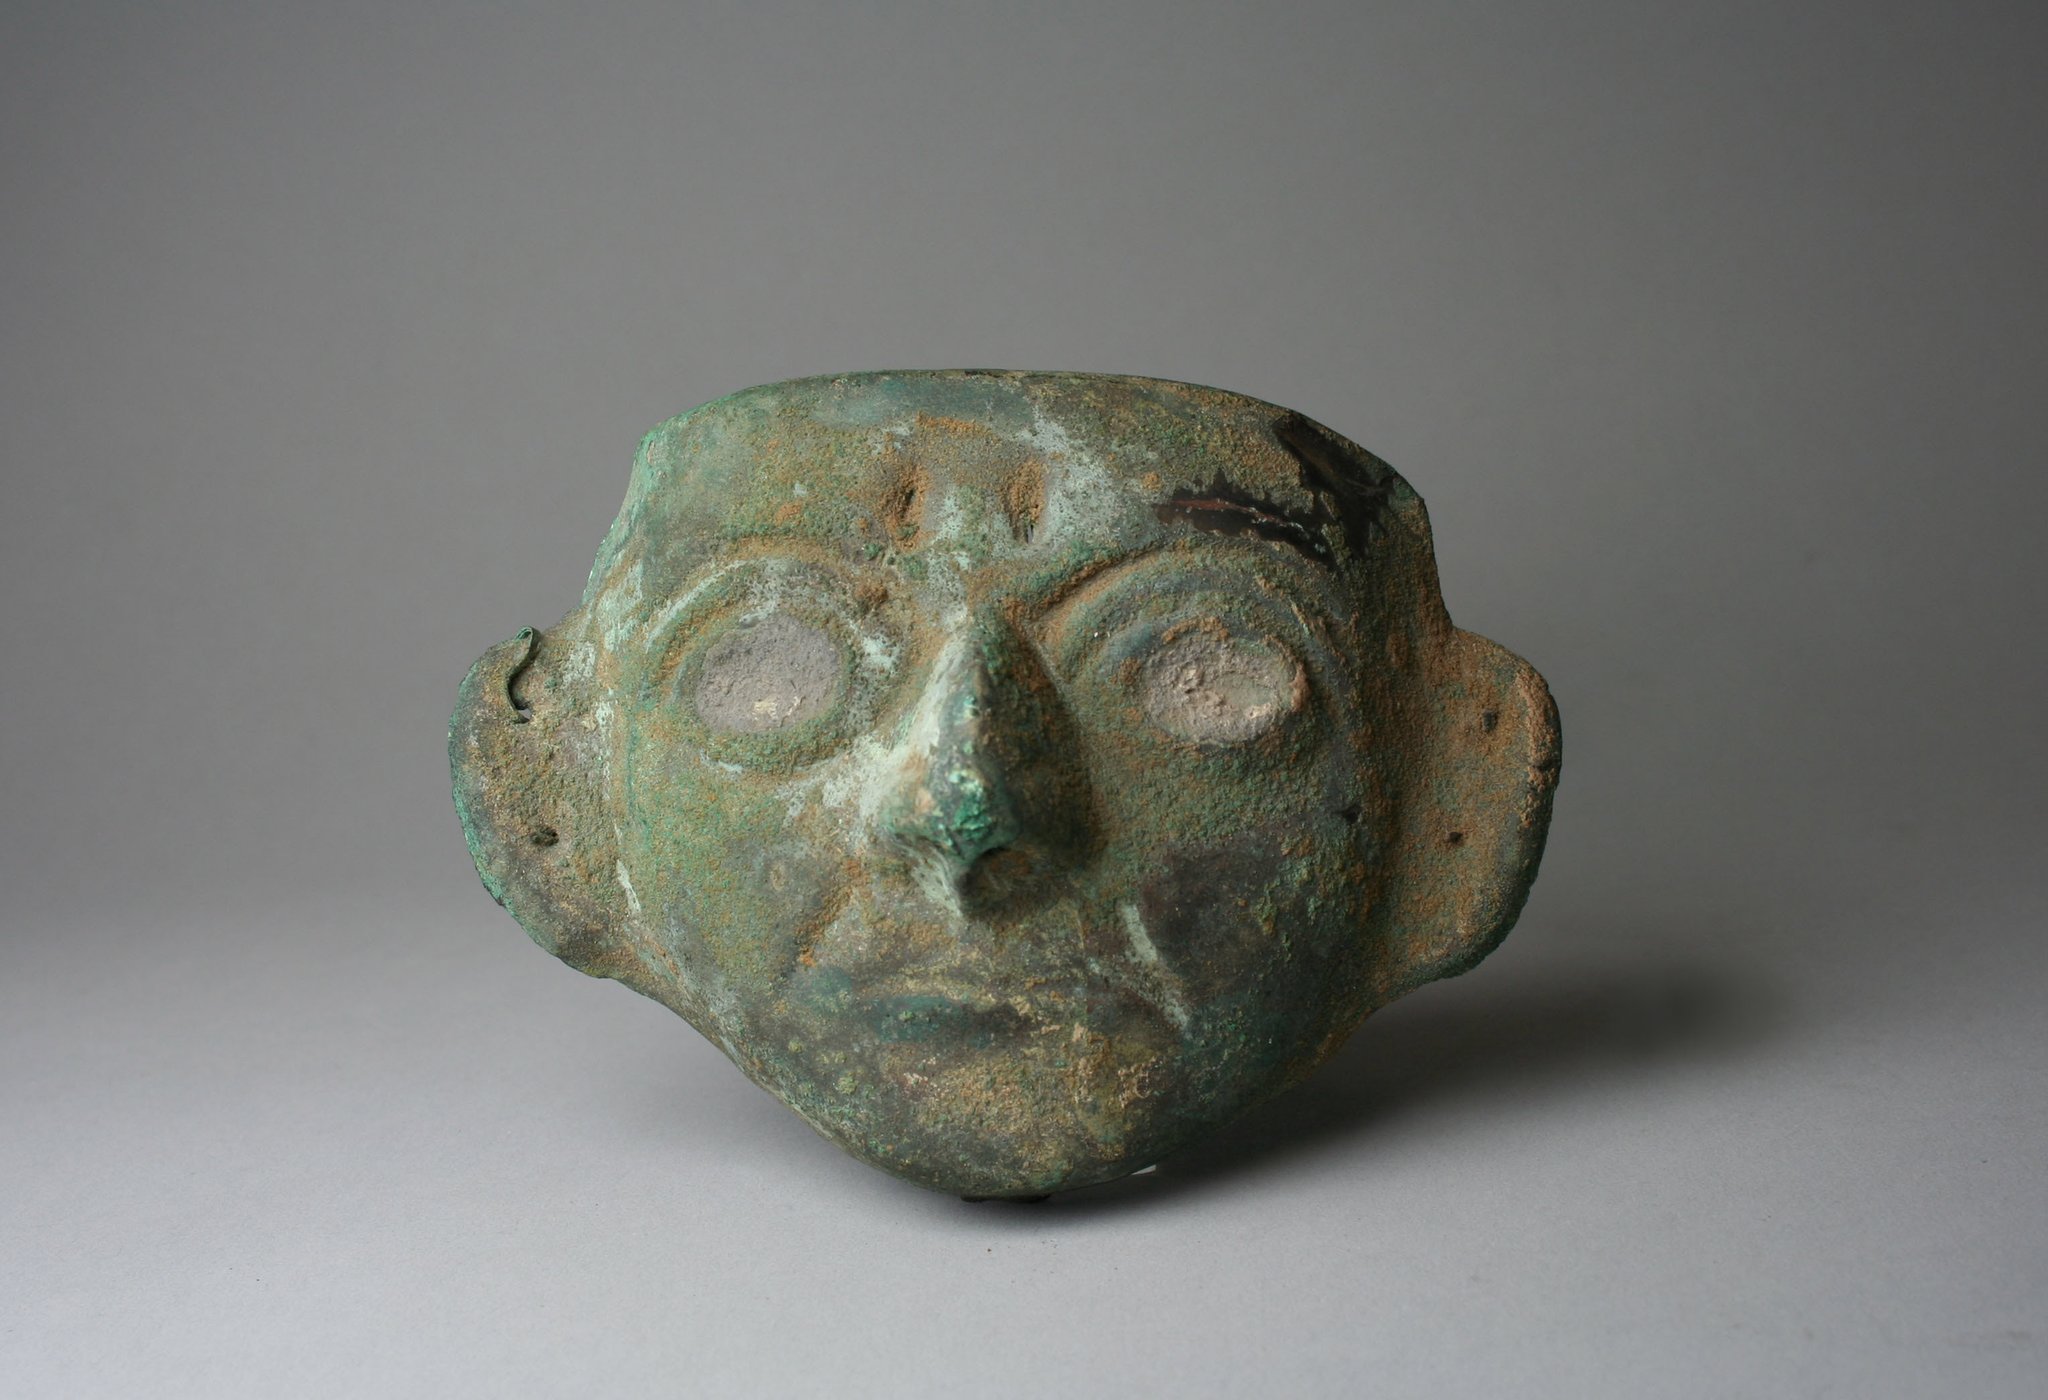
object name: ornament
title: Face Mask Ornament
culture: moche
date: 501-700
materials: metal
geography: peru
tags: faces